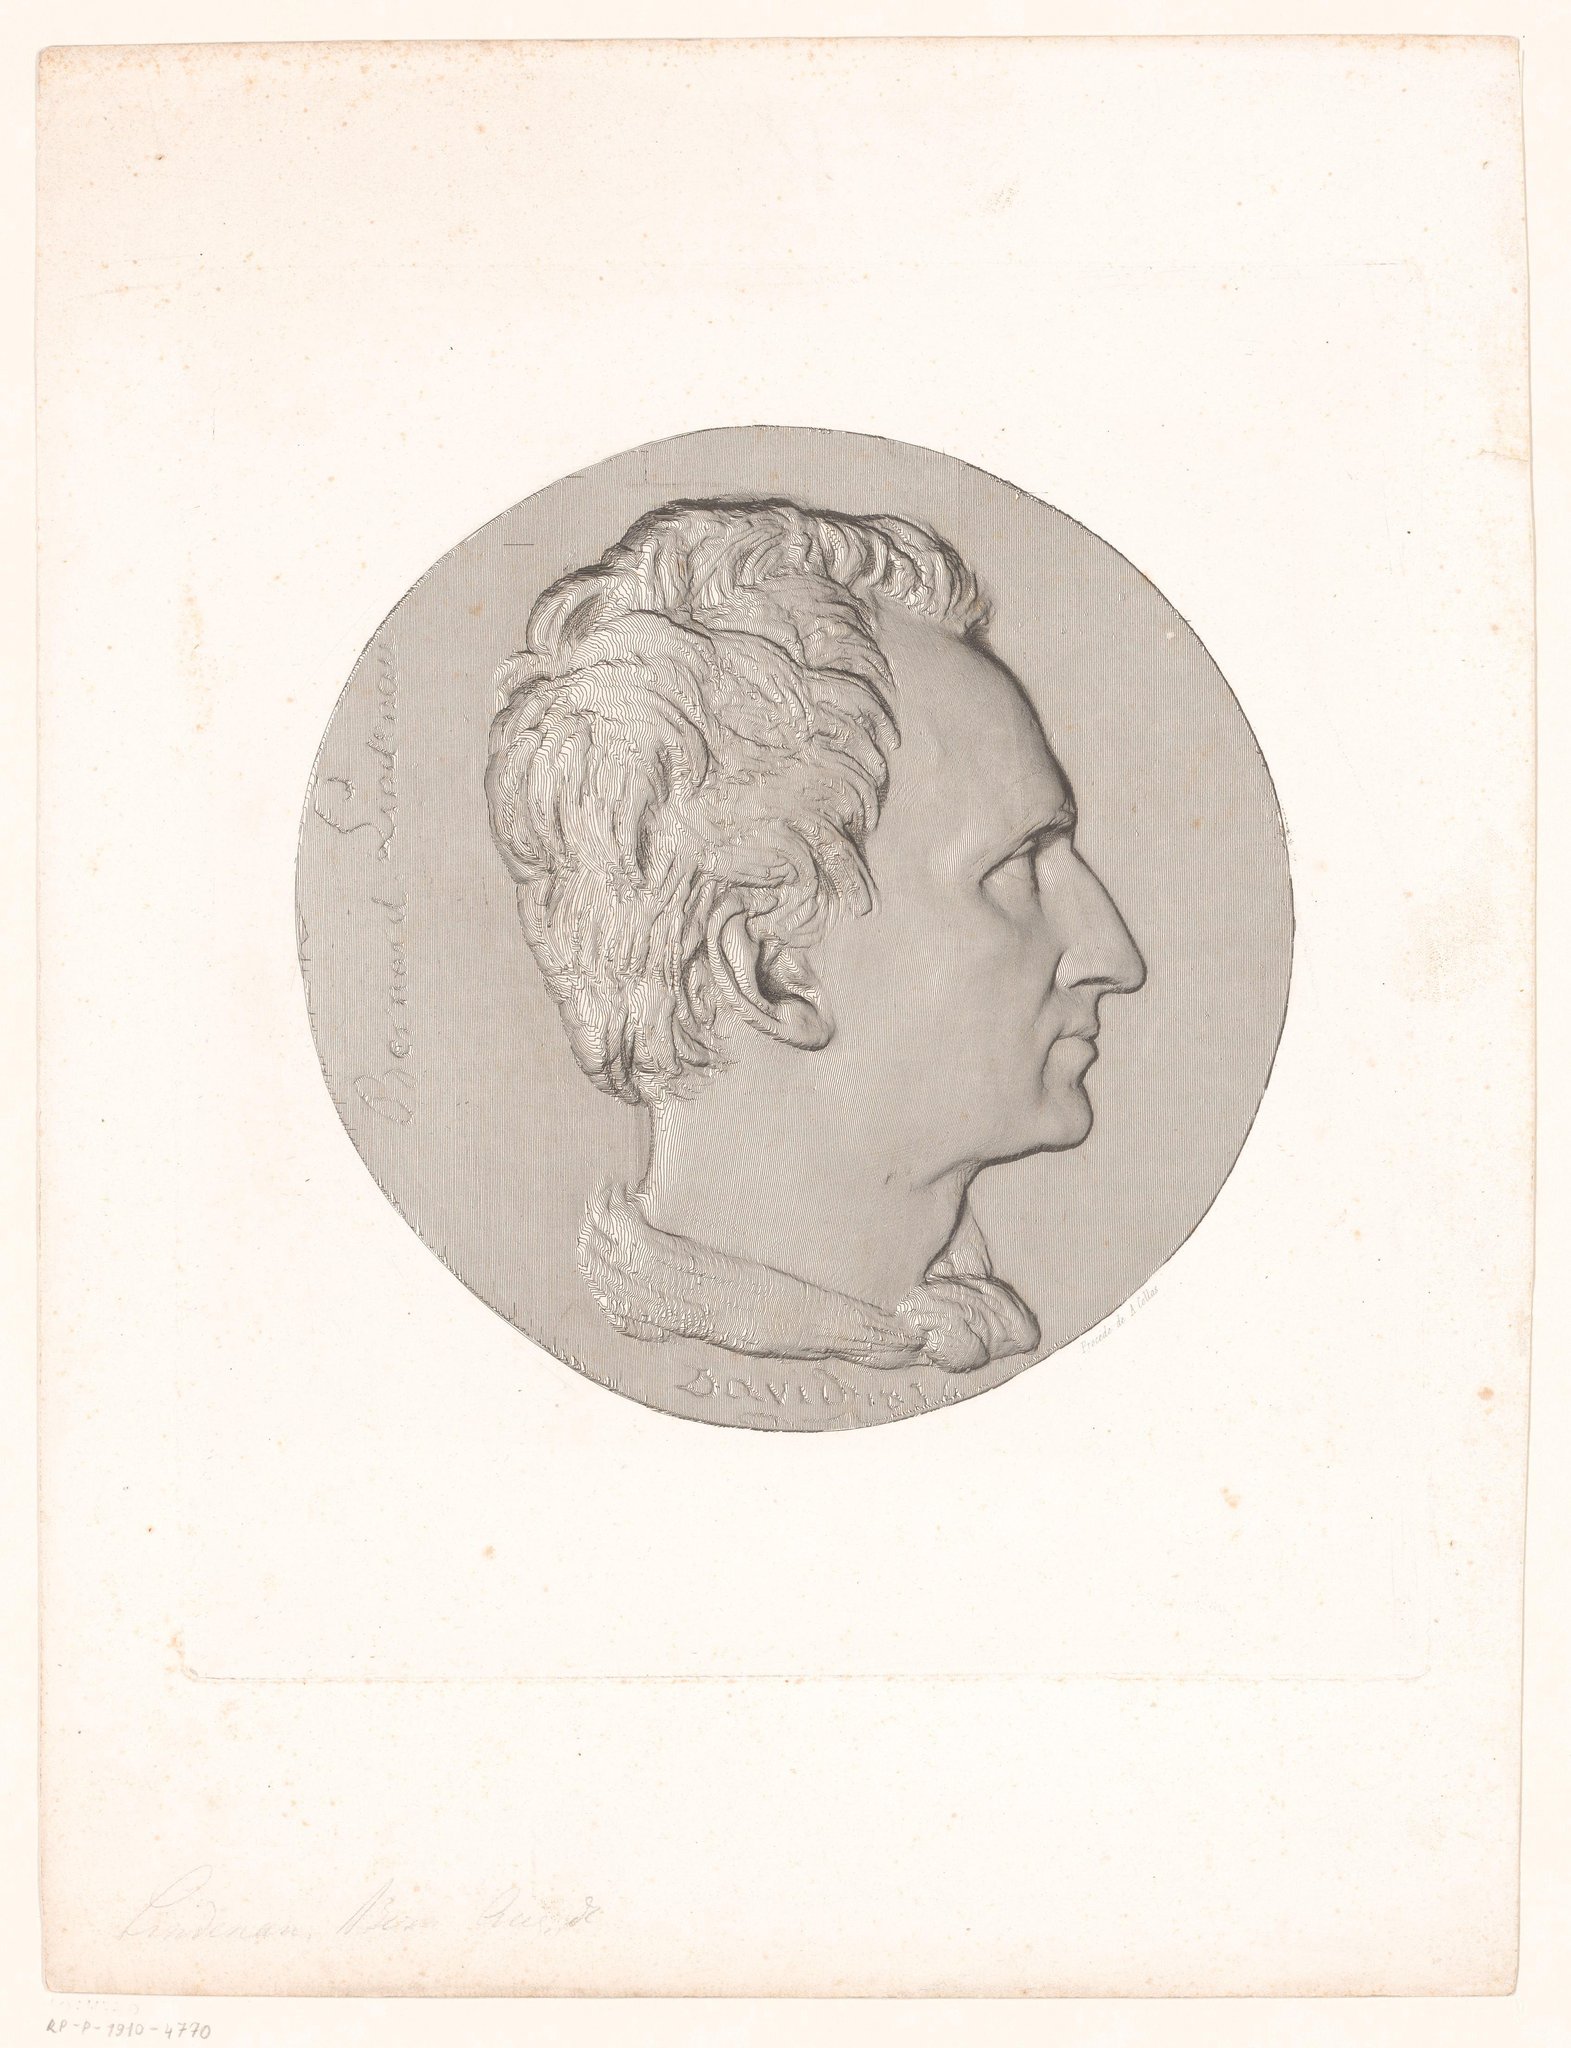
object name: print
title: Medaille met portret van Bernhard von Lindenau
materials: paper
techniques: relief engraving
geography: france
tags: ornament ~ medallion, historical persons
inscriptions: collector's mark: Lugt 2228